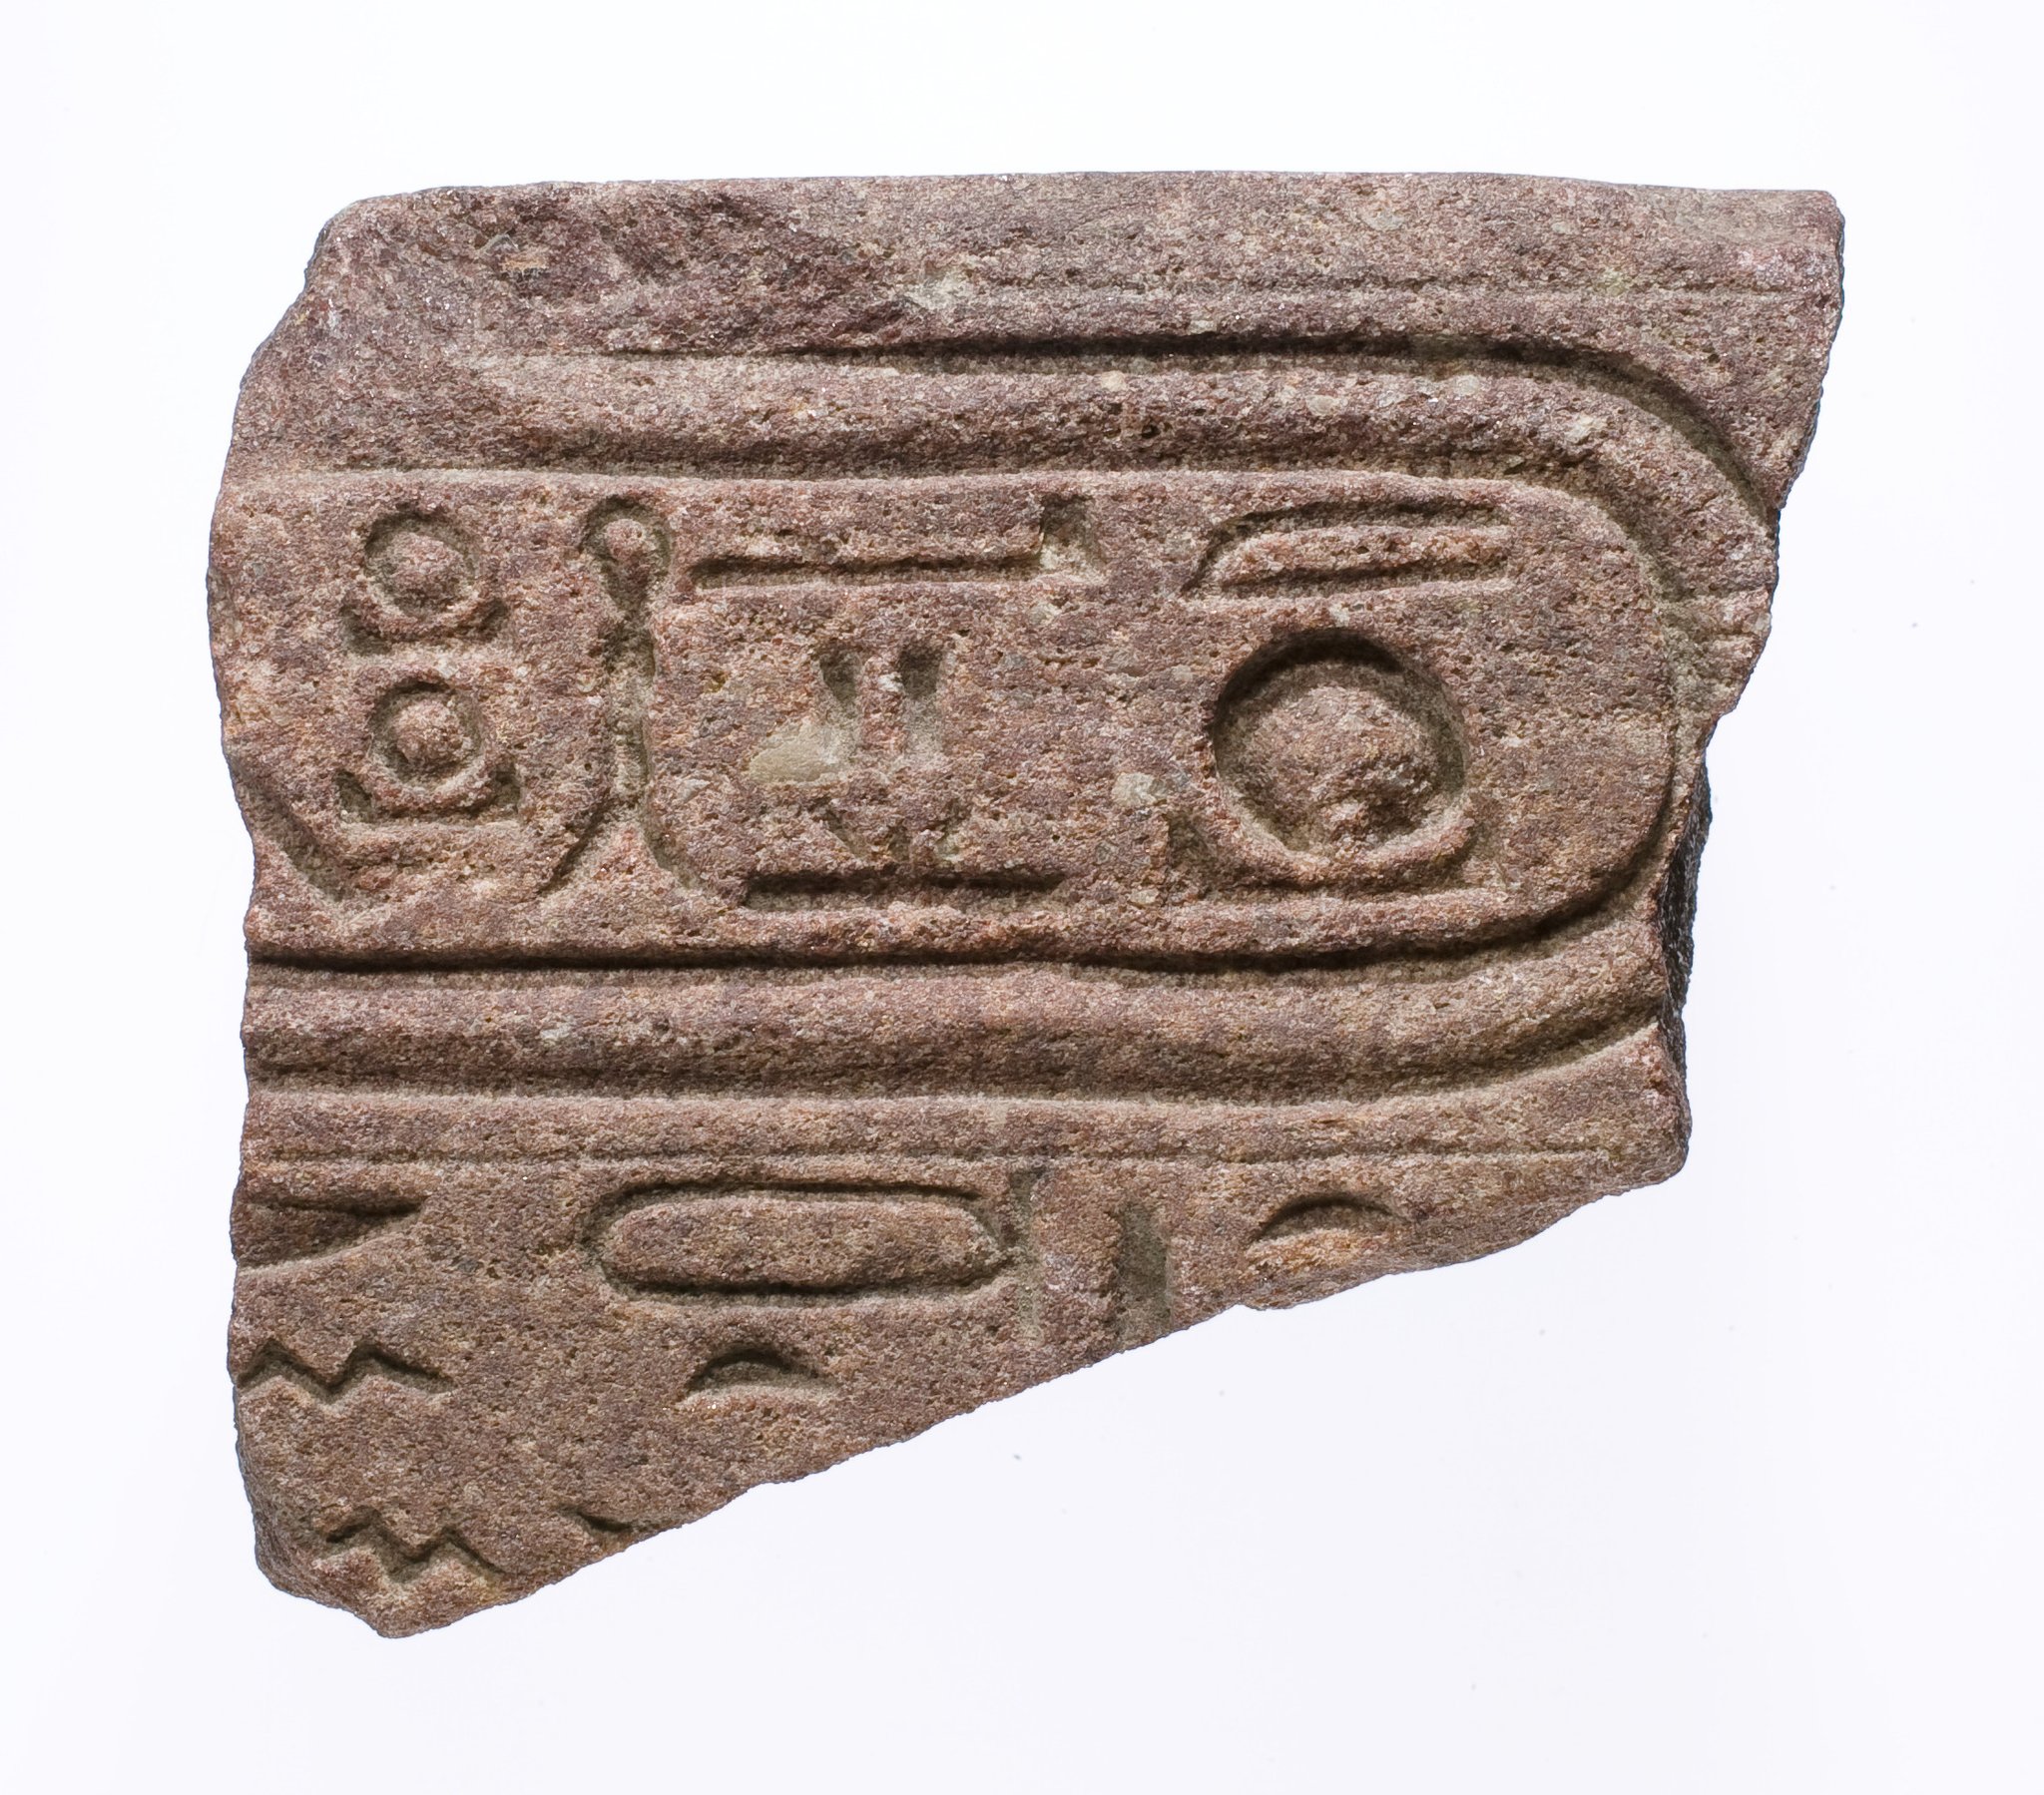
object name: aten cartouche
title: Element with name and epithets of the Aten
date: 1353-1336 BCE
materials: quartzite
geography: egypt